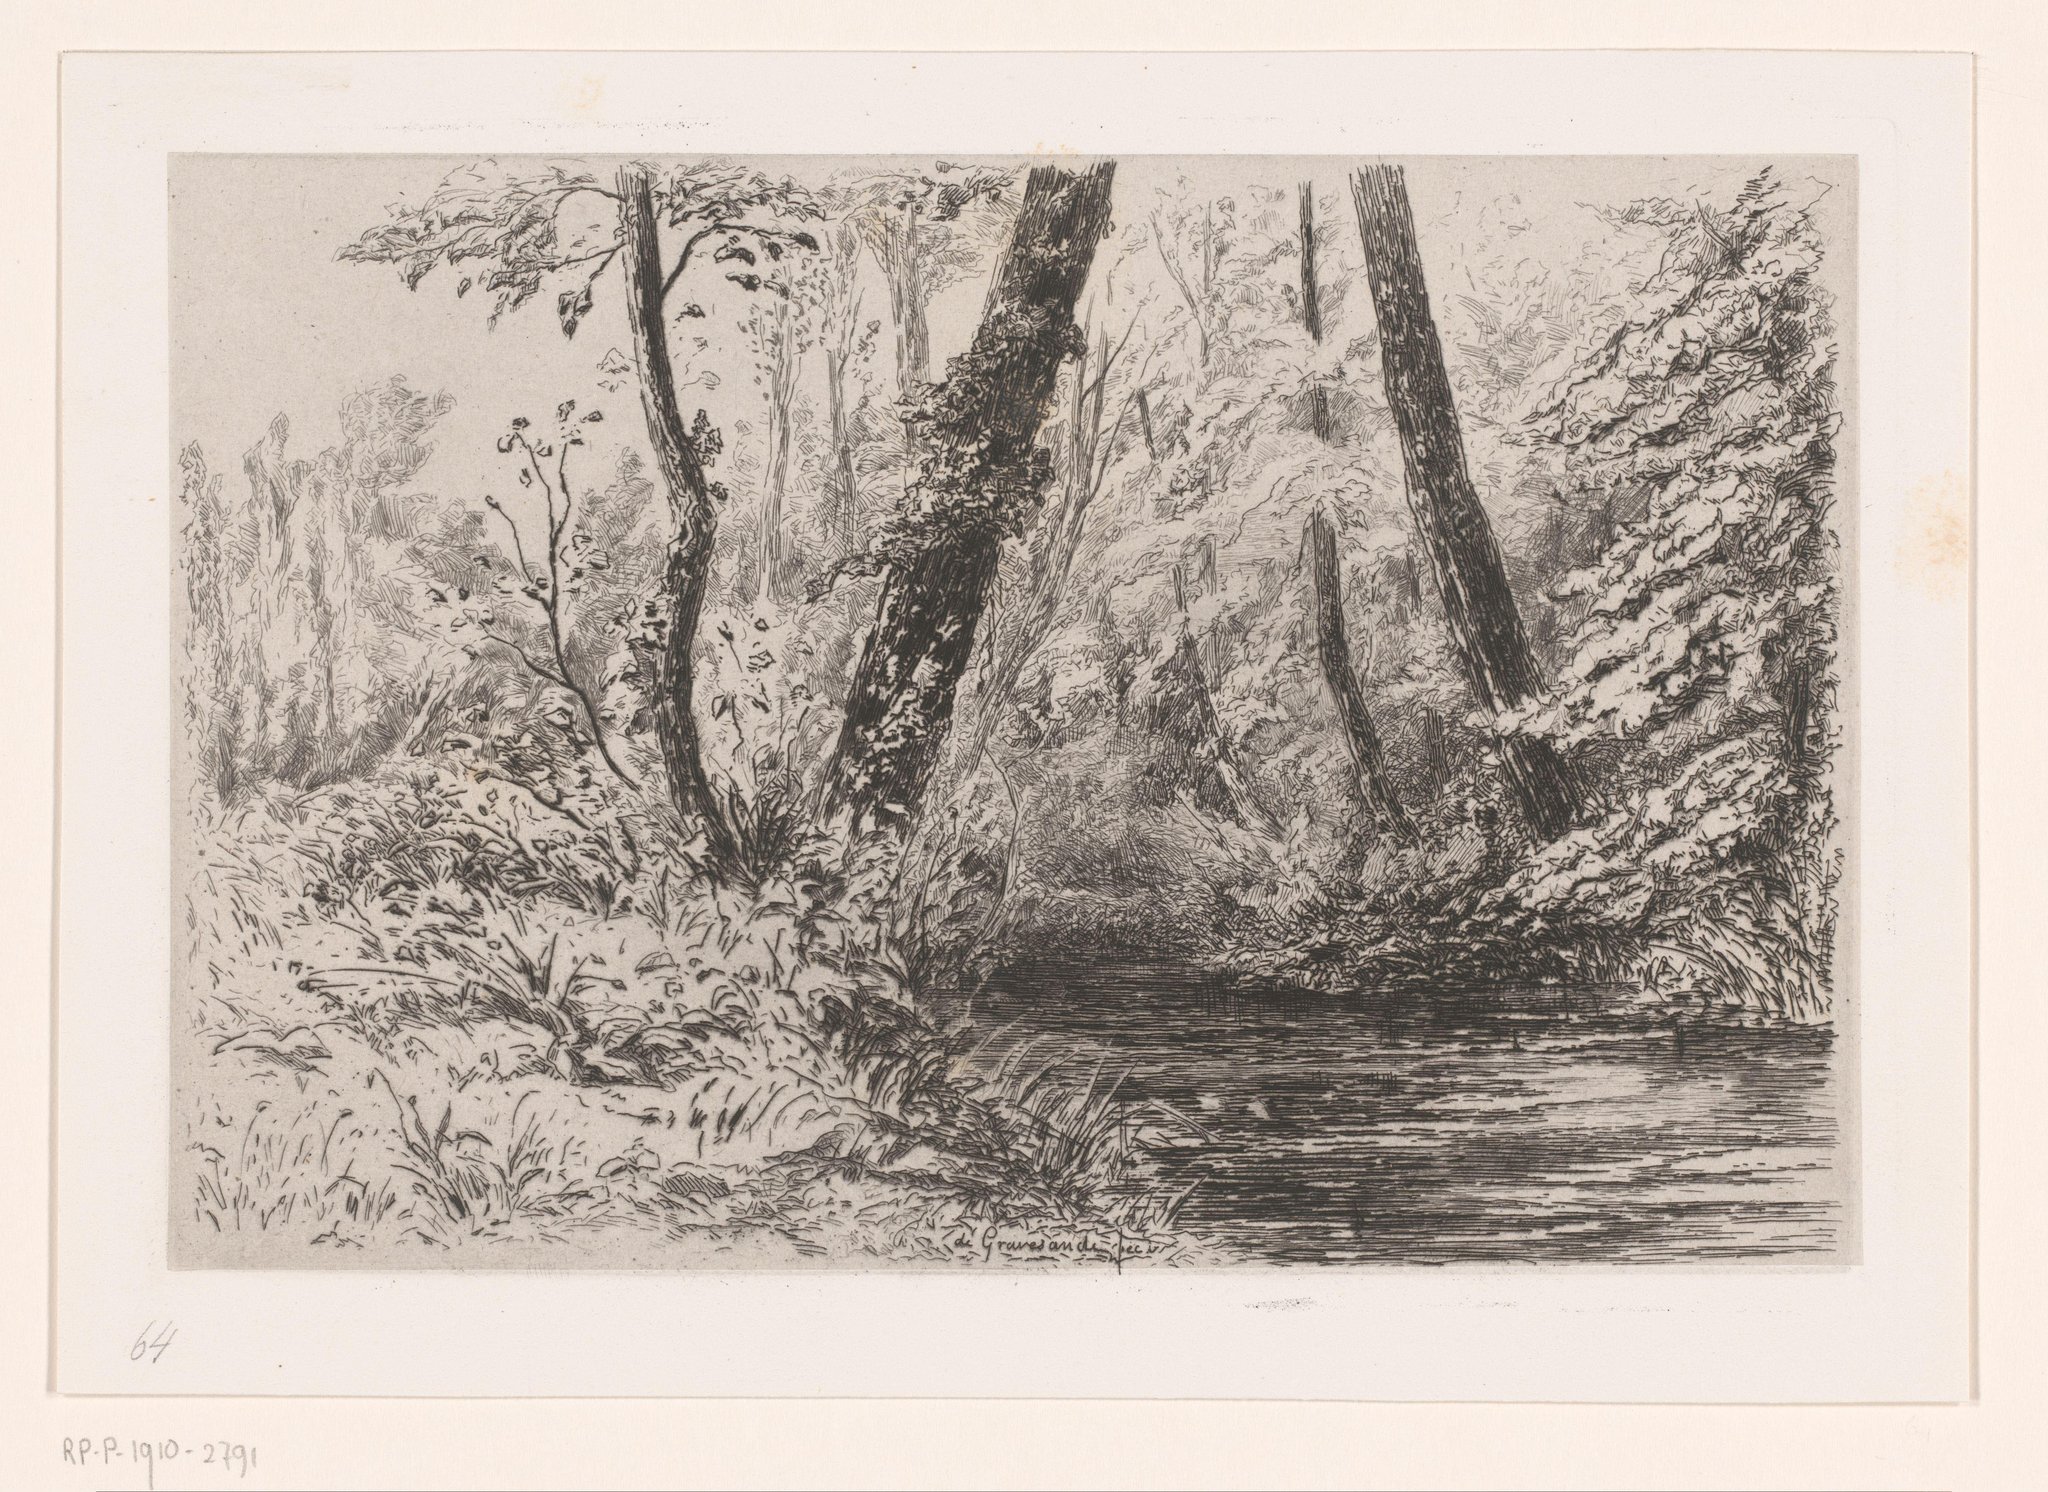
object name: print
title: Au bord de la Veule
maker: carel nicolaas storm van s-gravesande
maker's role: draughtsman, print maker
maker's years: 1841-1924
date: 1873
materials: paper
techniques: etching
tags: river, forest, wood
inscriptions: collector's mark: Lugt 2228